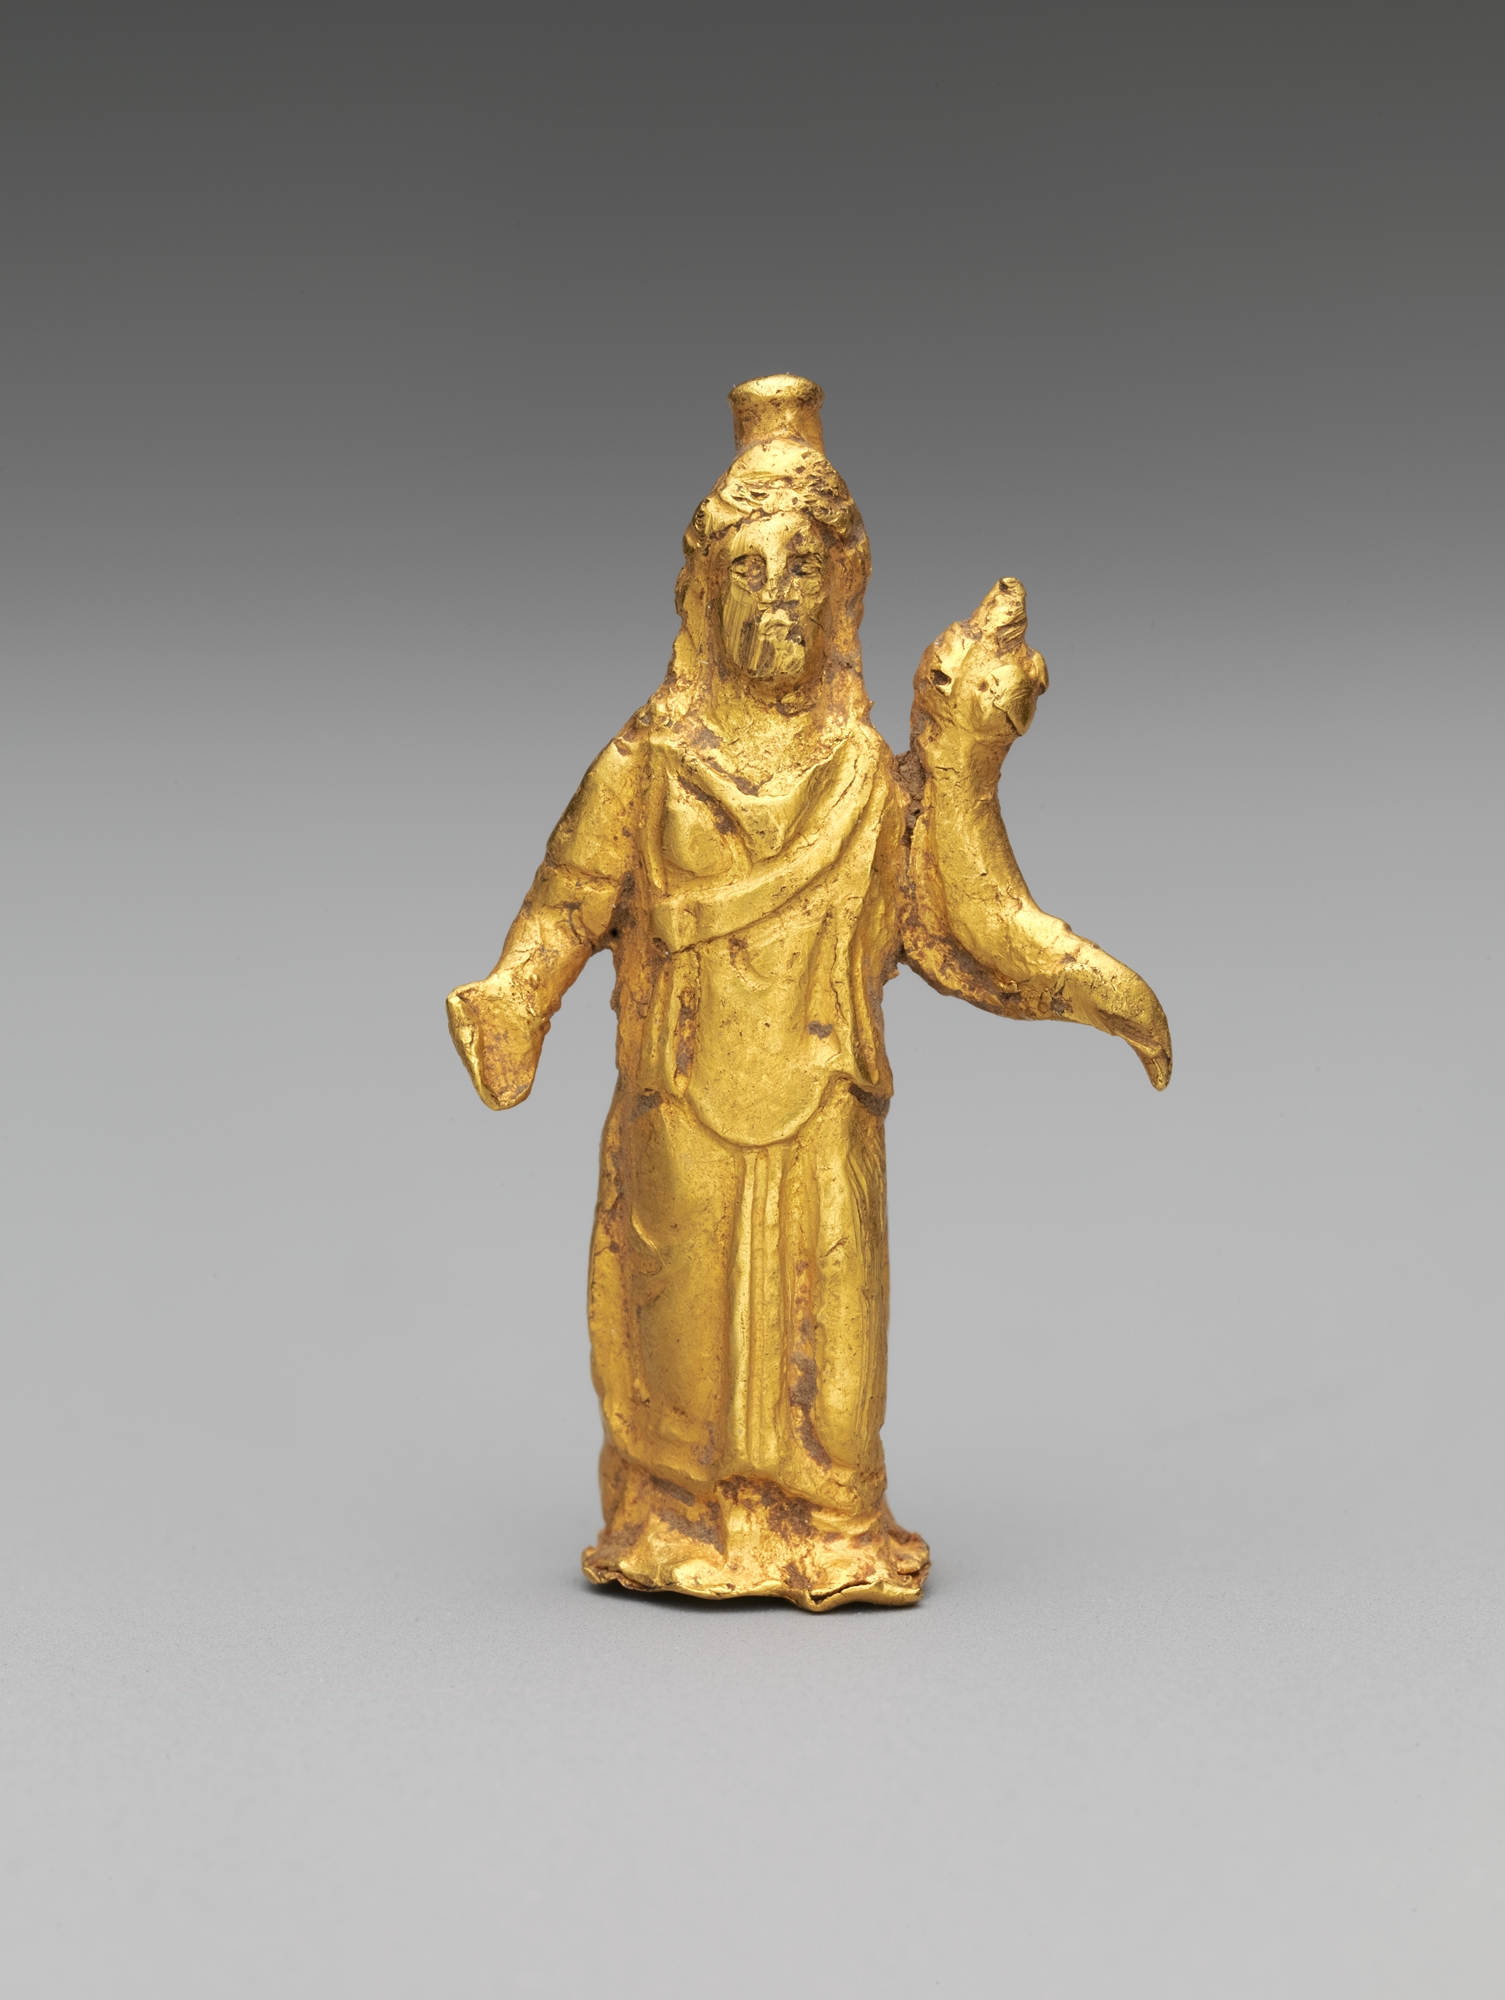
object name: statuette of a figure with cornucopia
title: Gold statuette of Zeus Serapis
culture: roman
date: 101-200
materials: gold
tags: zeus,cornucopia